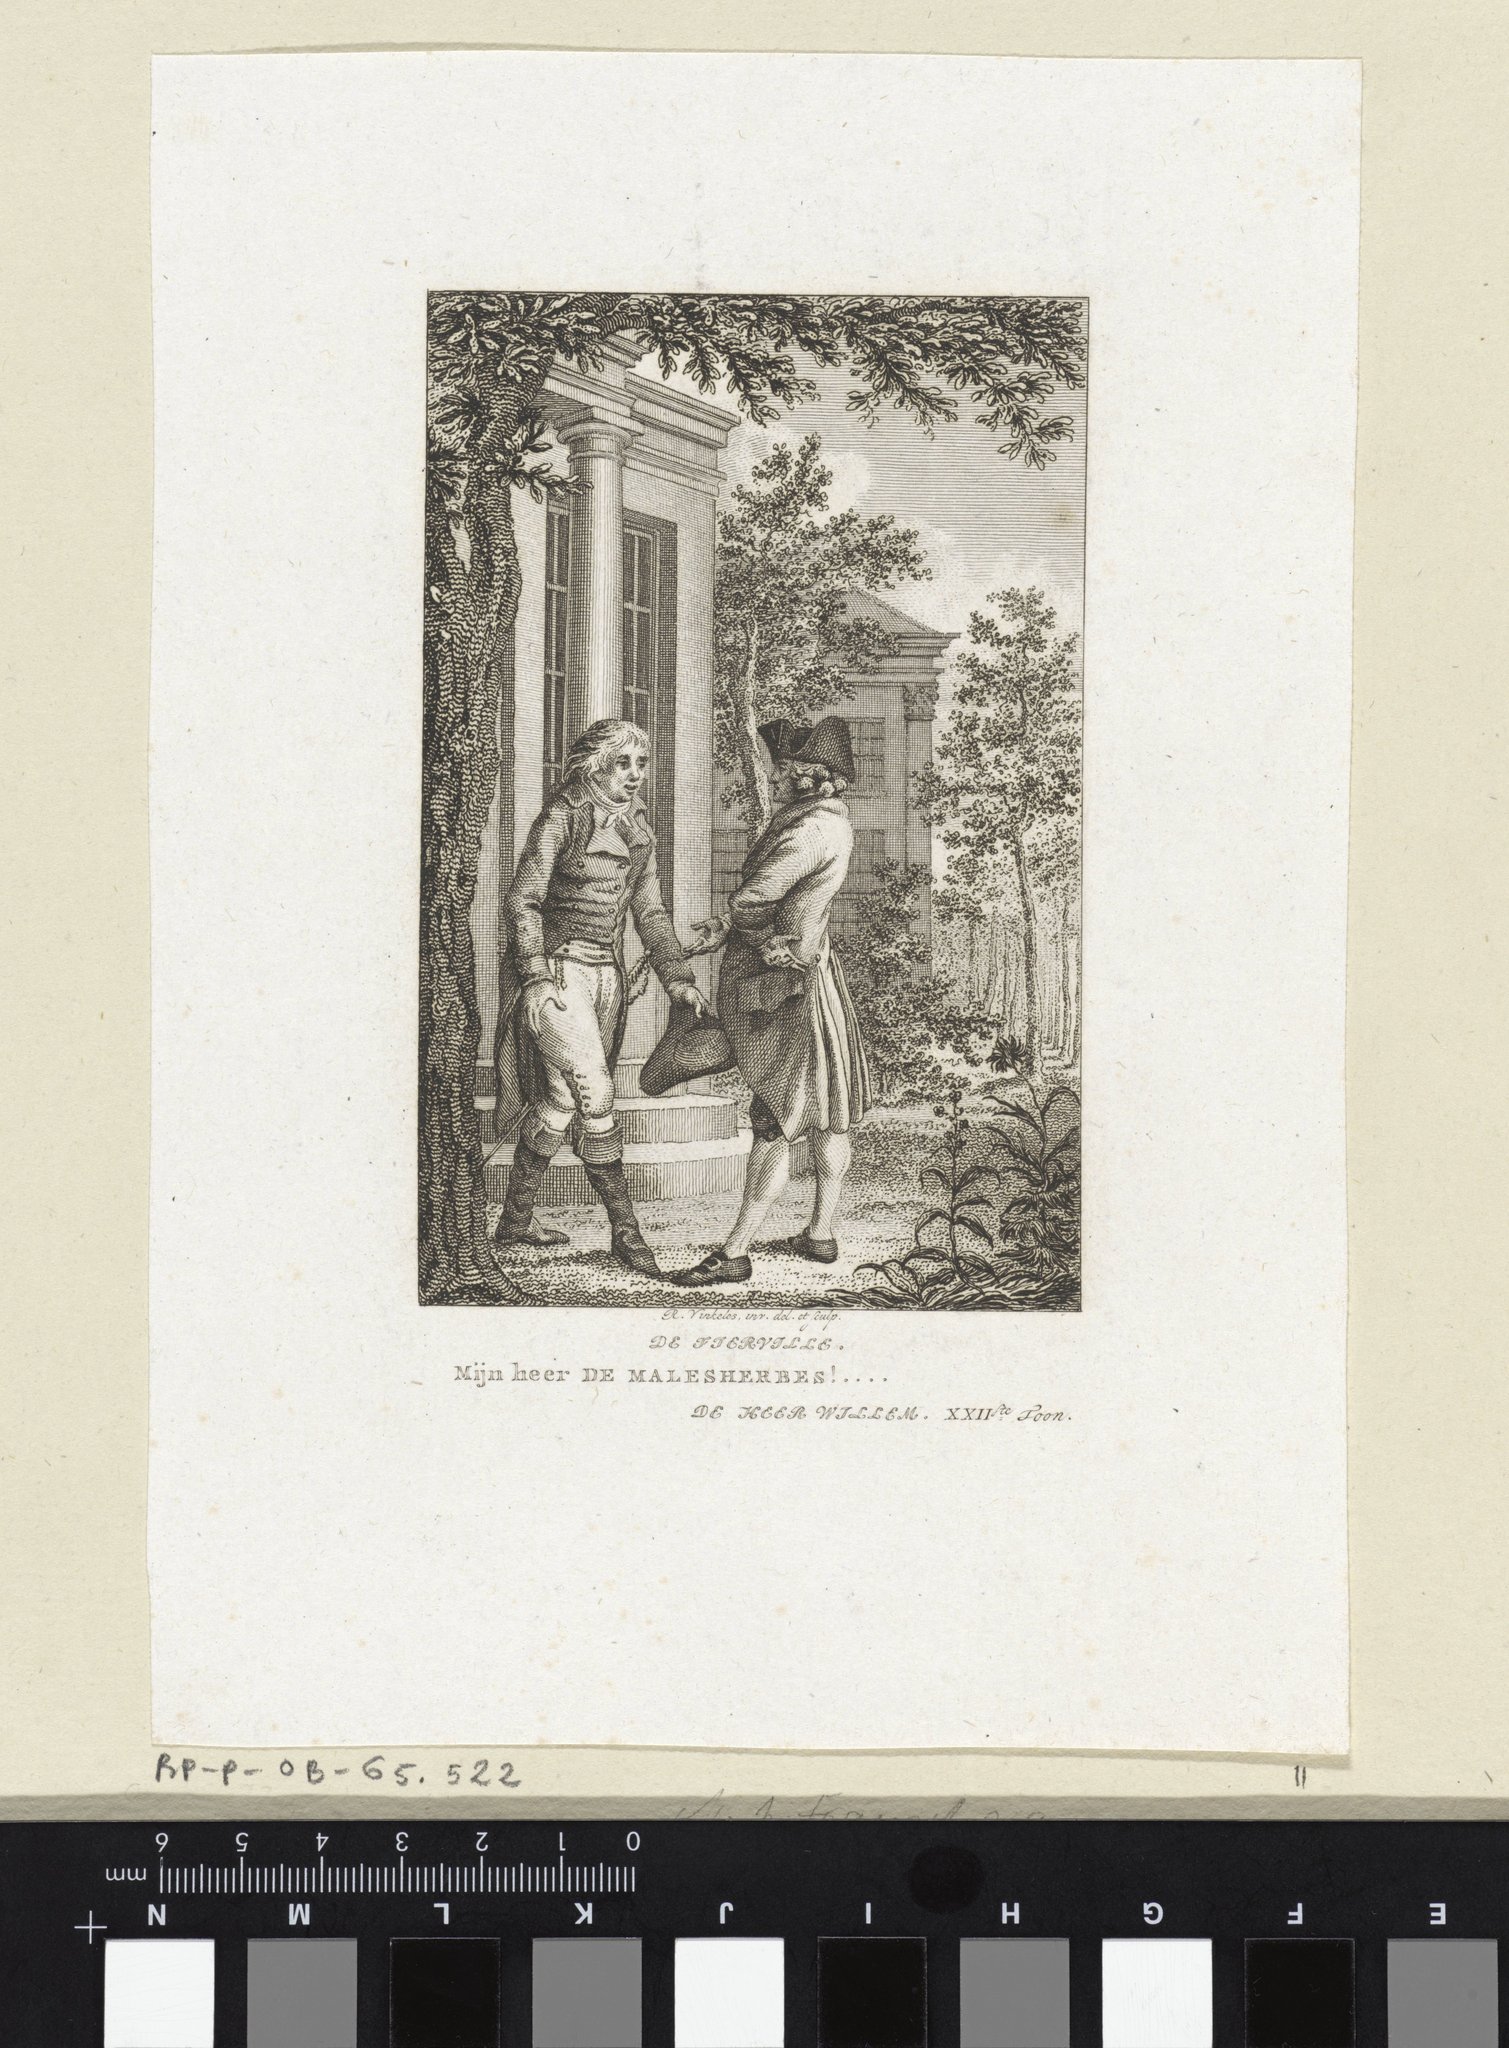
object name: print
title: Twee mannen ontmoeten elkaar in de tuin voor een huis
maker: reinier vinkeles (i)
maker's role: draughtsman, print maker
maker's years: 1741-1816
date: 1800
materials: paper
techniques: engraving, etching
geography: amsterdam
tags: conversation, dialogue; conversation piece, meeting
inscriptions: collector's mark: Lugt 240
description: Deze prent is mogelijk ook gebruikt als illustratie in: Barré, Radet. De heer Willem, of De onbekende reiziger. Amsterdam: Gerrit Warnars, 1800.